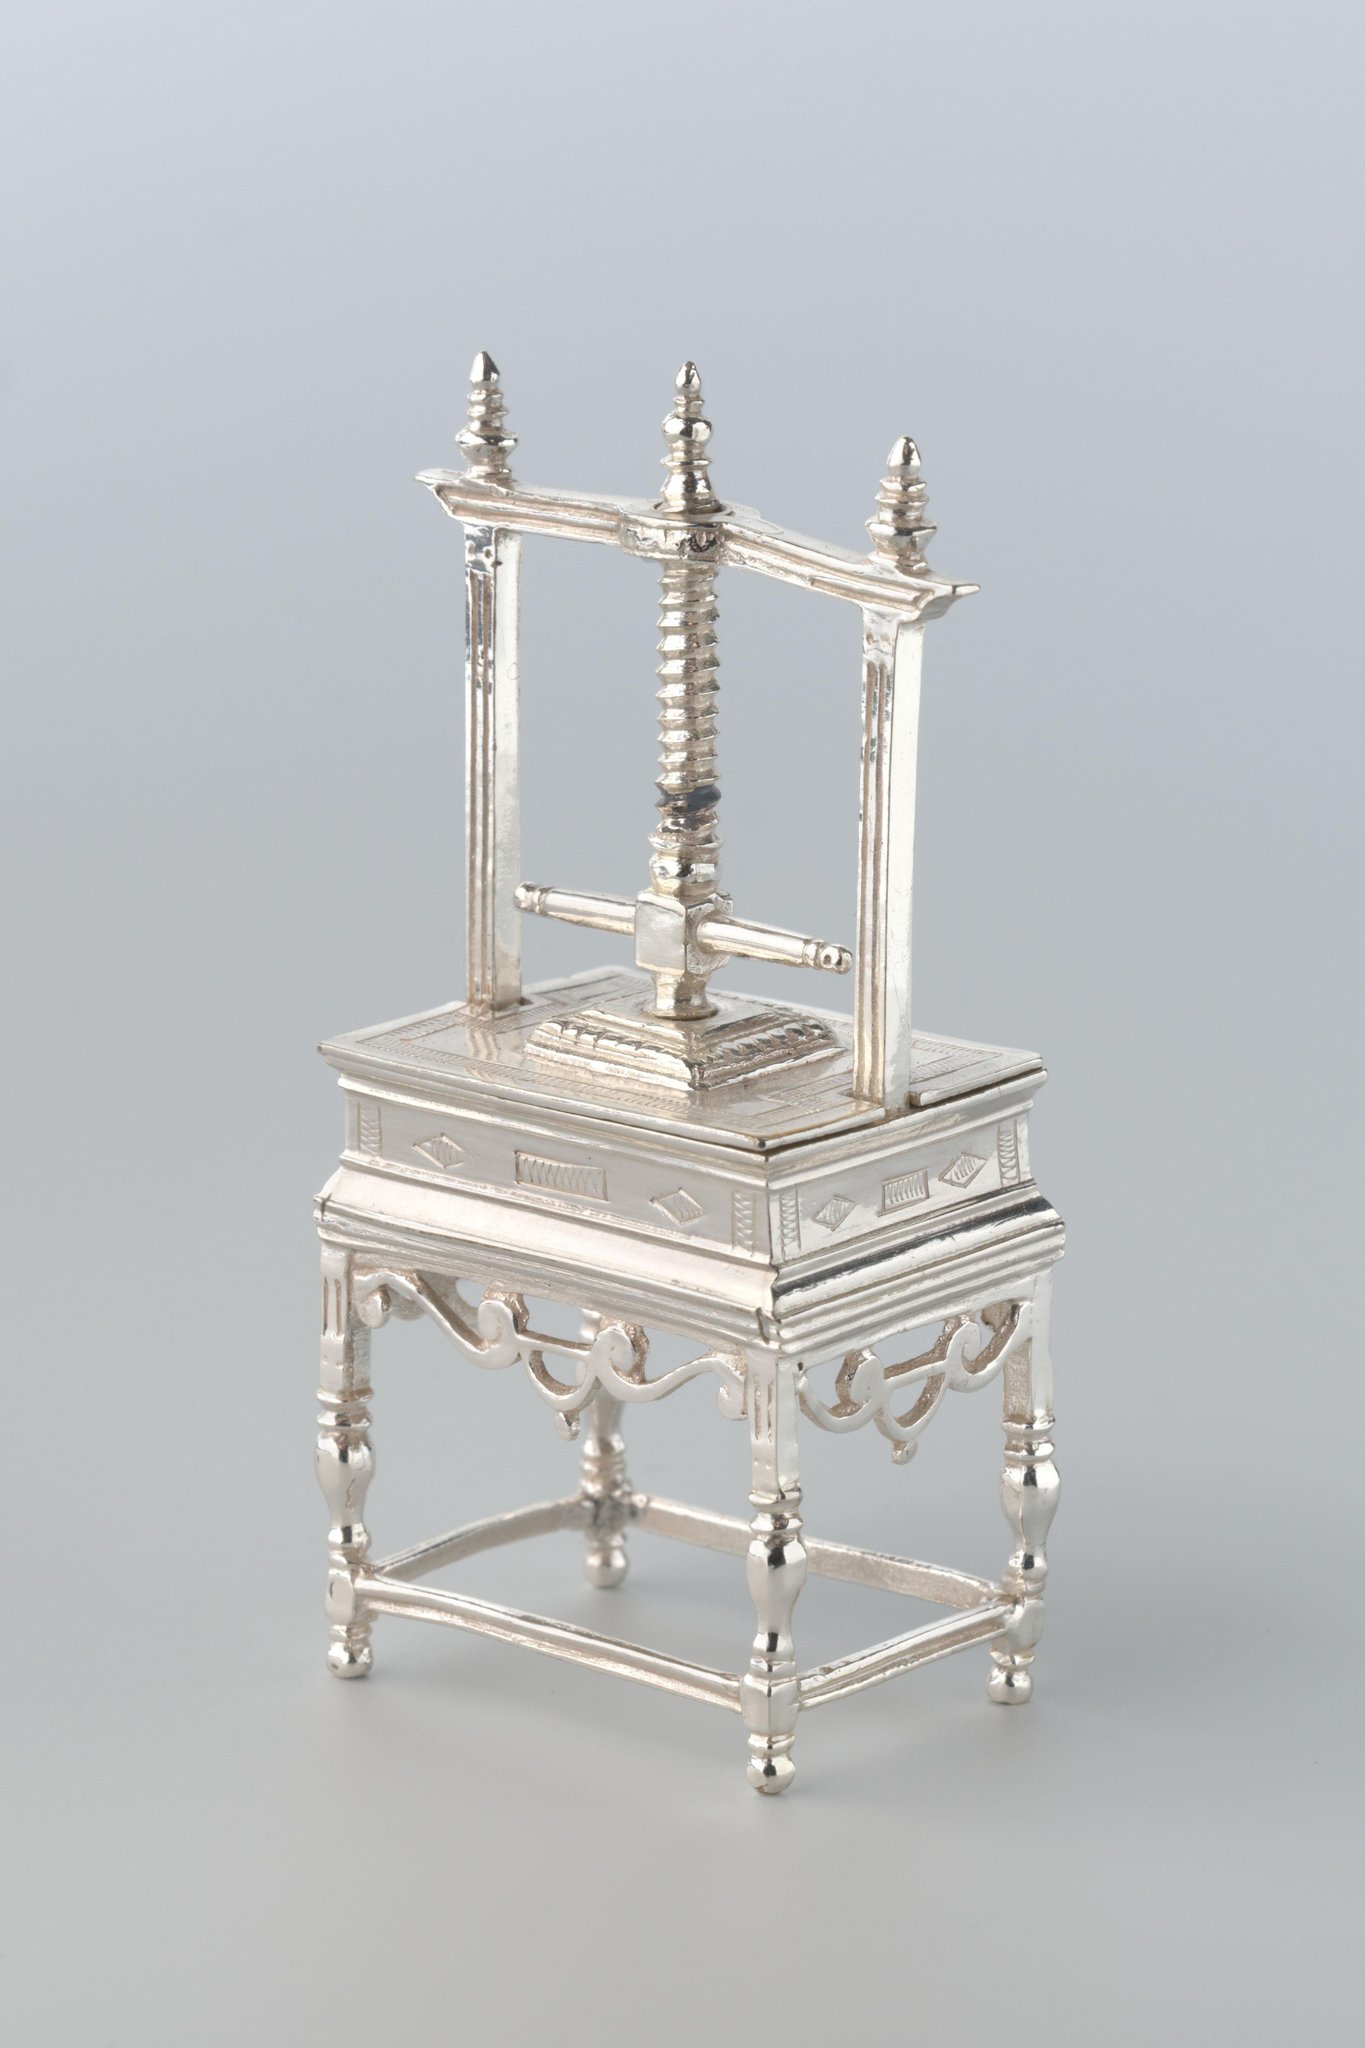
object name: linen press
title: Linnenpers van zilver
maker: Anonymous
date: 1675-1725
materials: silver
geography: amsterdam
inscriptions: maker's mark: ‘kop of vuist in rond (Voet 1912, nr. 373; Citroen 1975, nr. 970?)’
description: Linnepers van zilver, versierd met graveerwerk (trembleerrand), opengewerkte volutenversiering tussen de poten, bovenstel met draaibaar plateau, zonder planken.